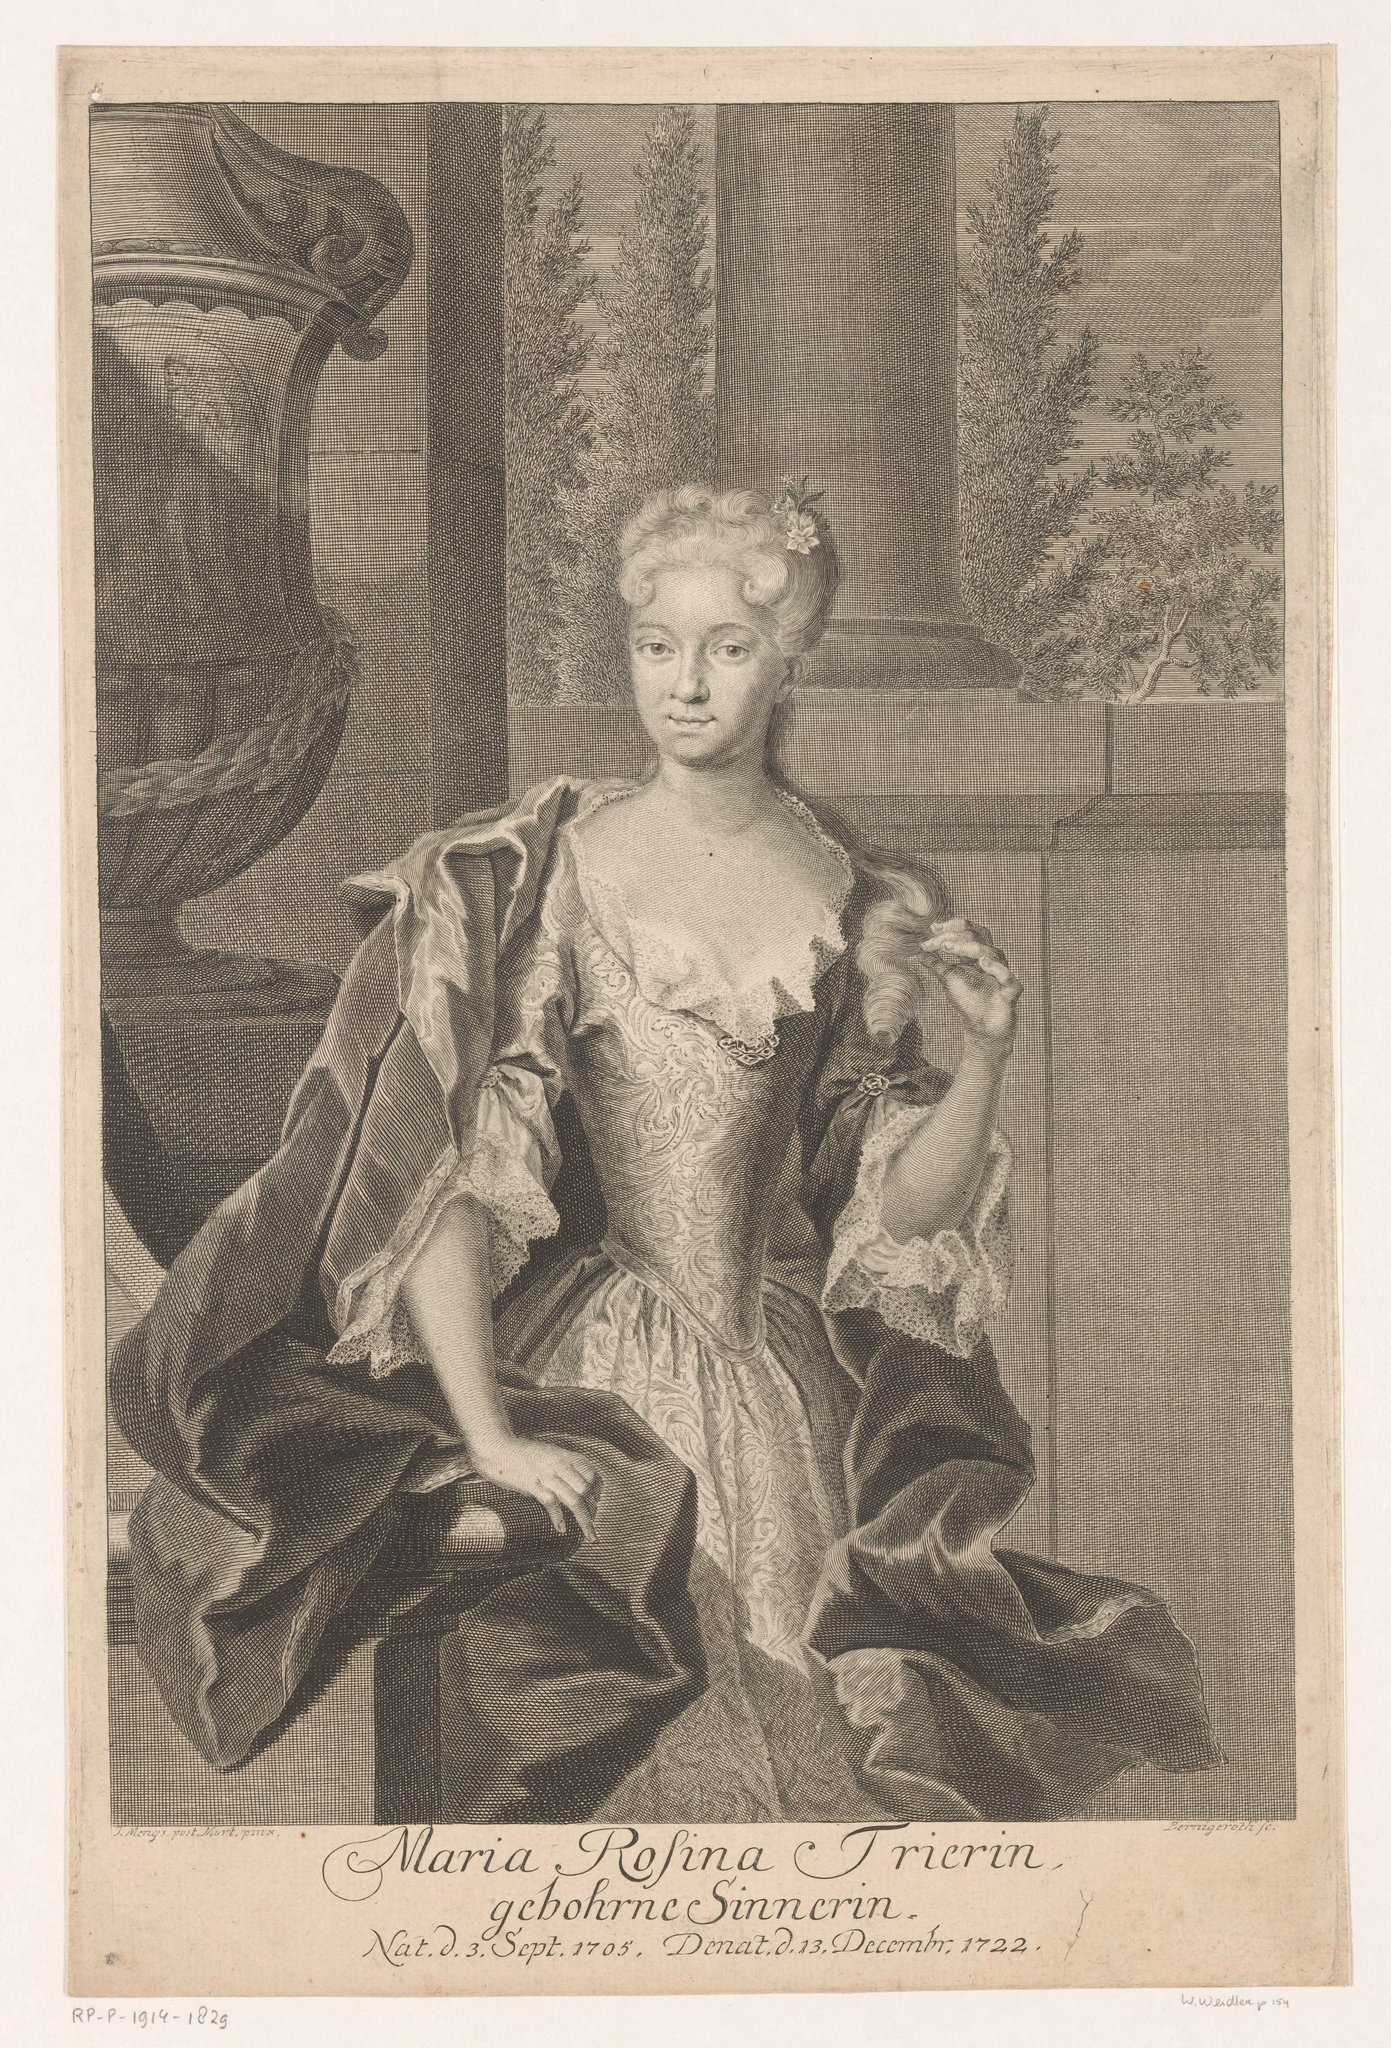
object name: print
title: Portret van Maria Rosina Trier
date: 1722-1733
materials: paper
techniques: engraving, etching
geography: leipzig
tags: historical persons - bb - woman, urn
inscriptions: collector's mark: Lugt 2228